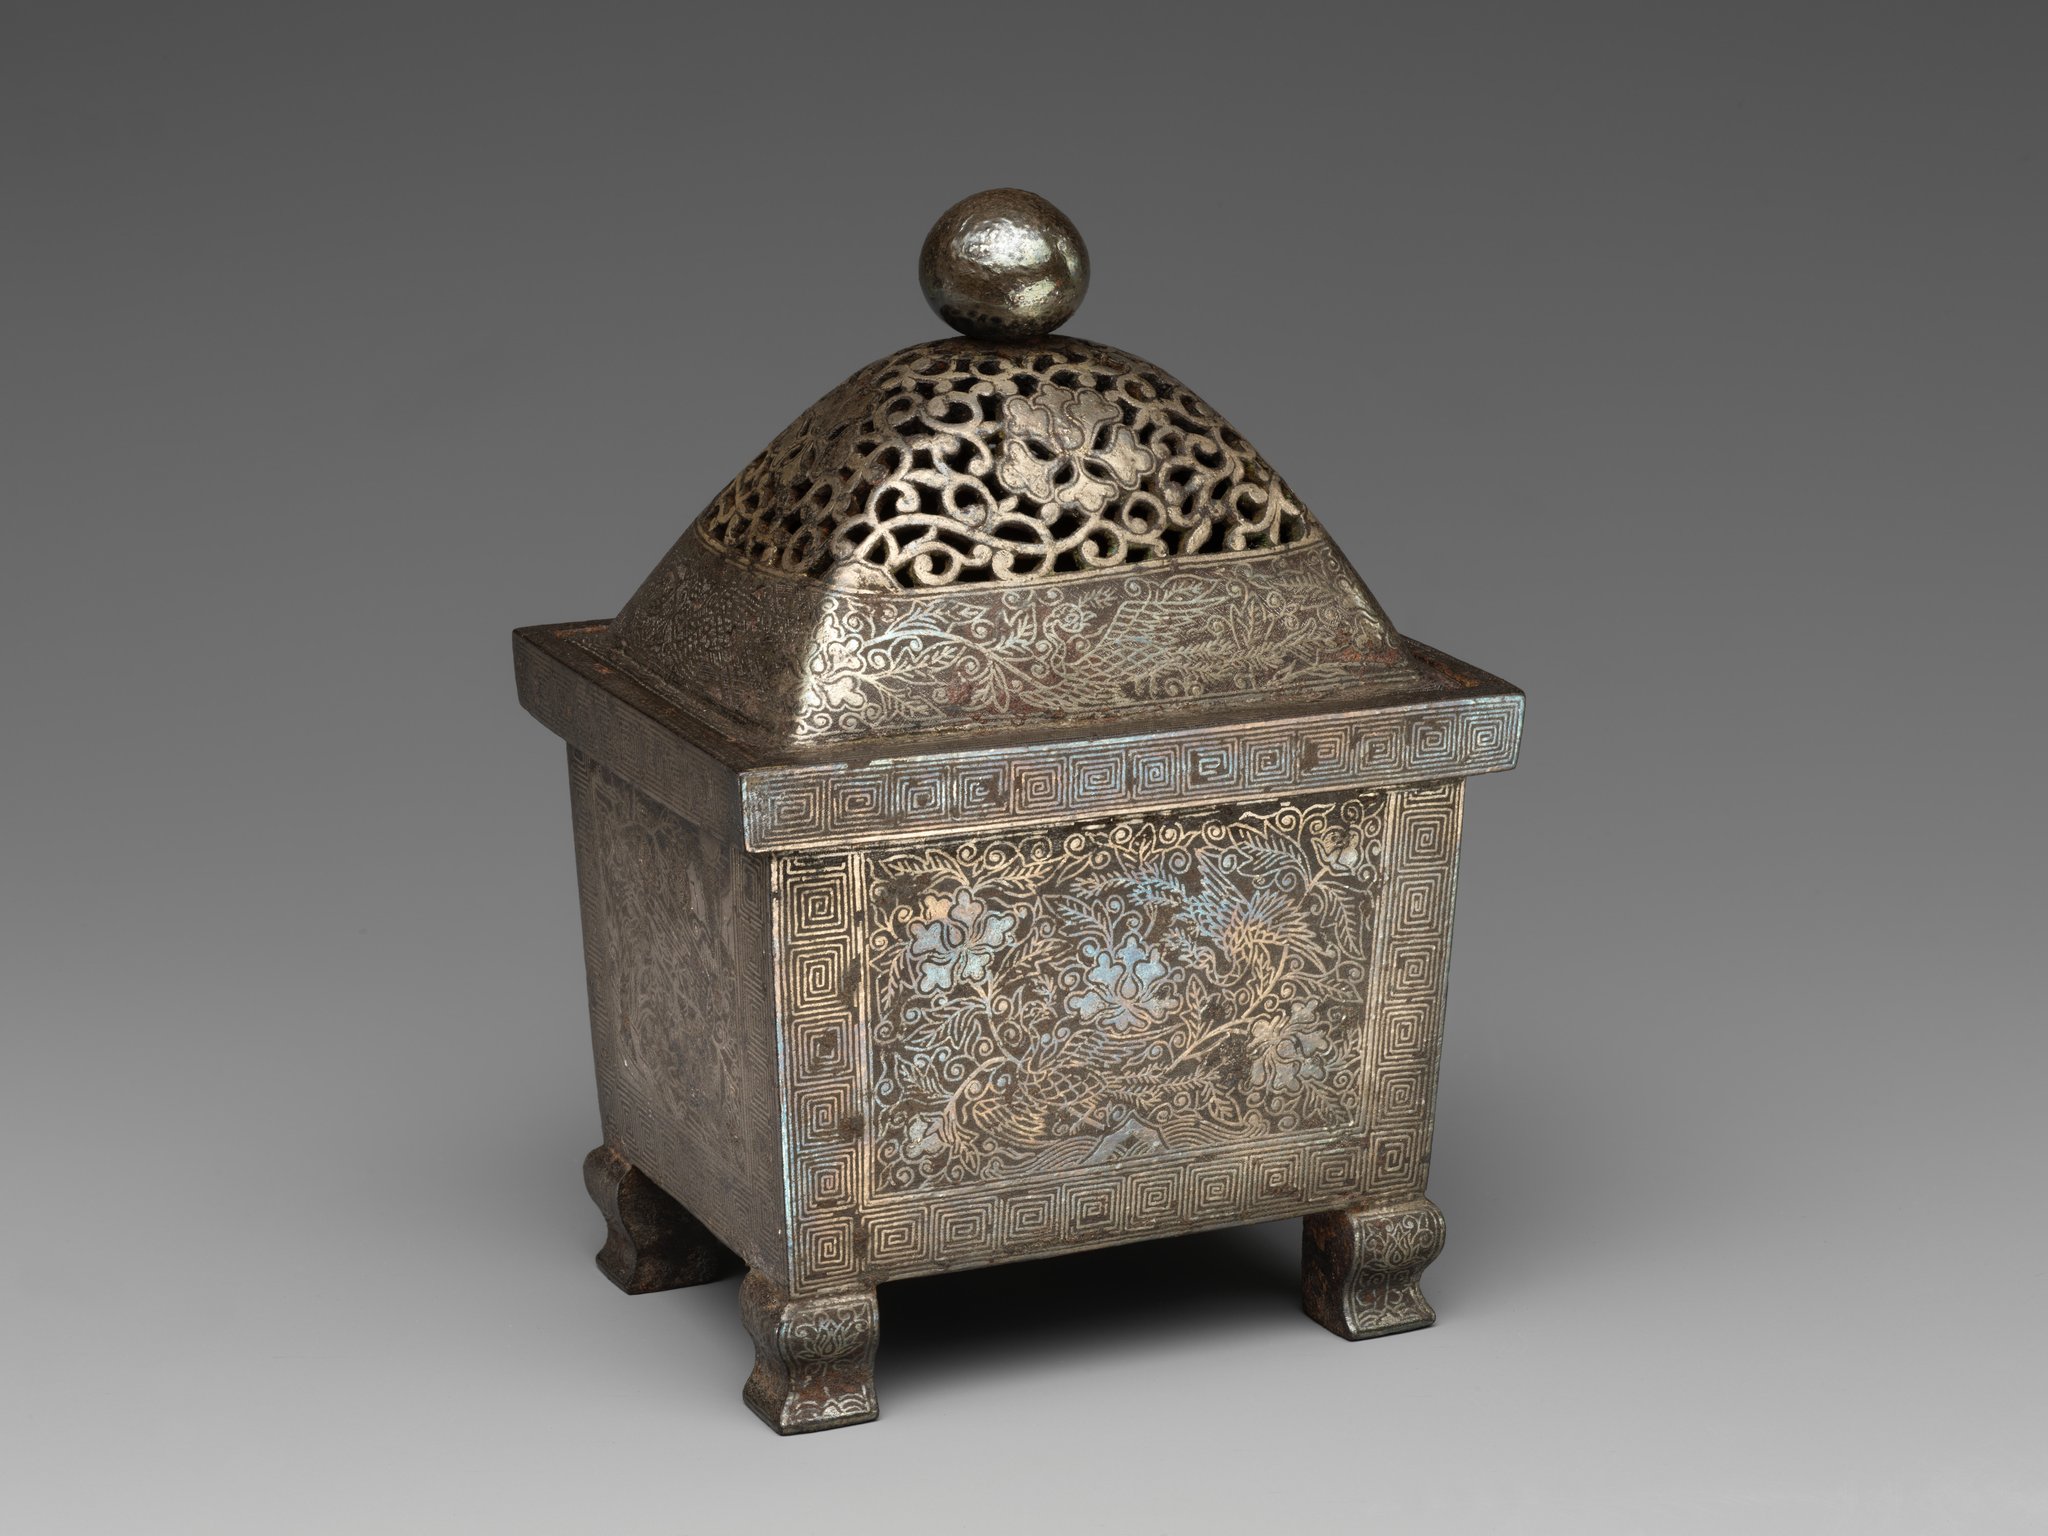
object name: incense burner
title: Incense burner with peacock and peony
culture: chinese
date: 1401-1600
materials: iron, silver